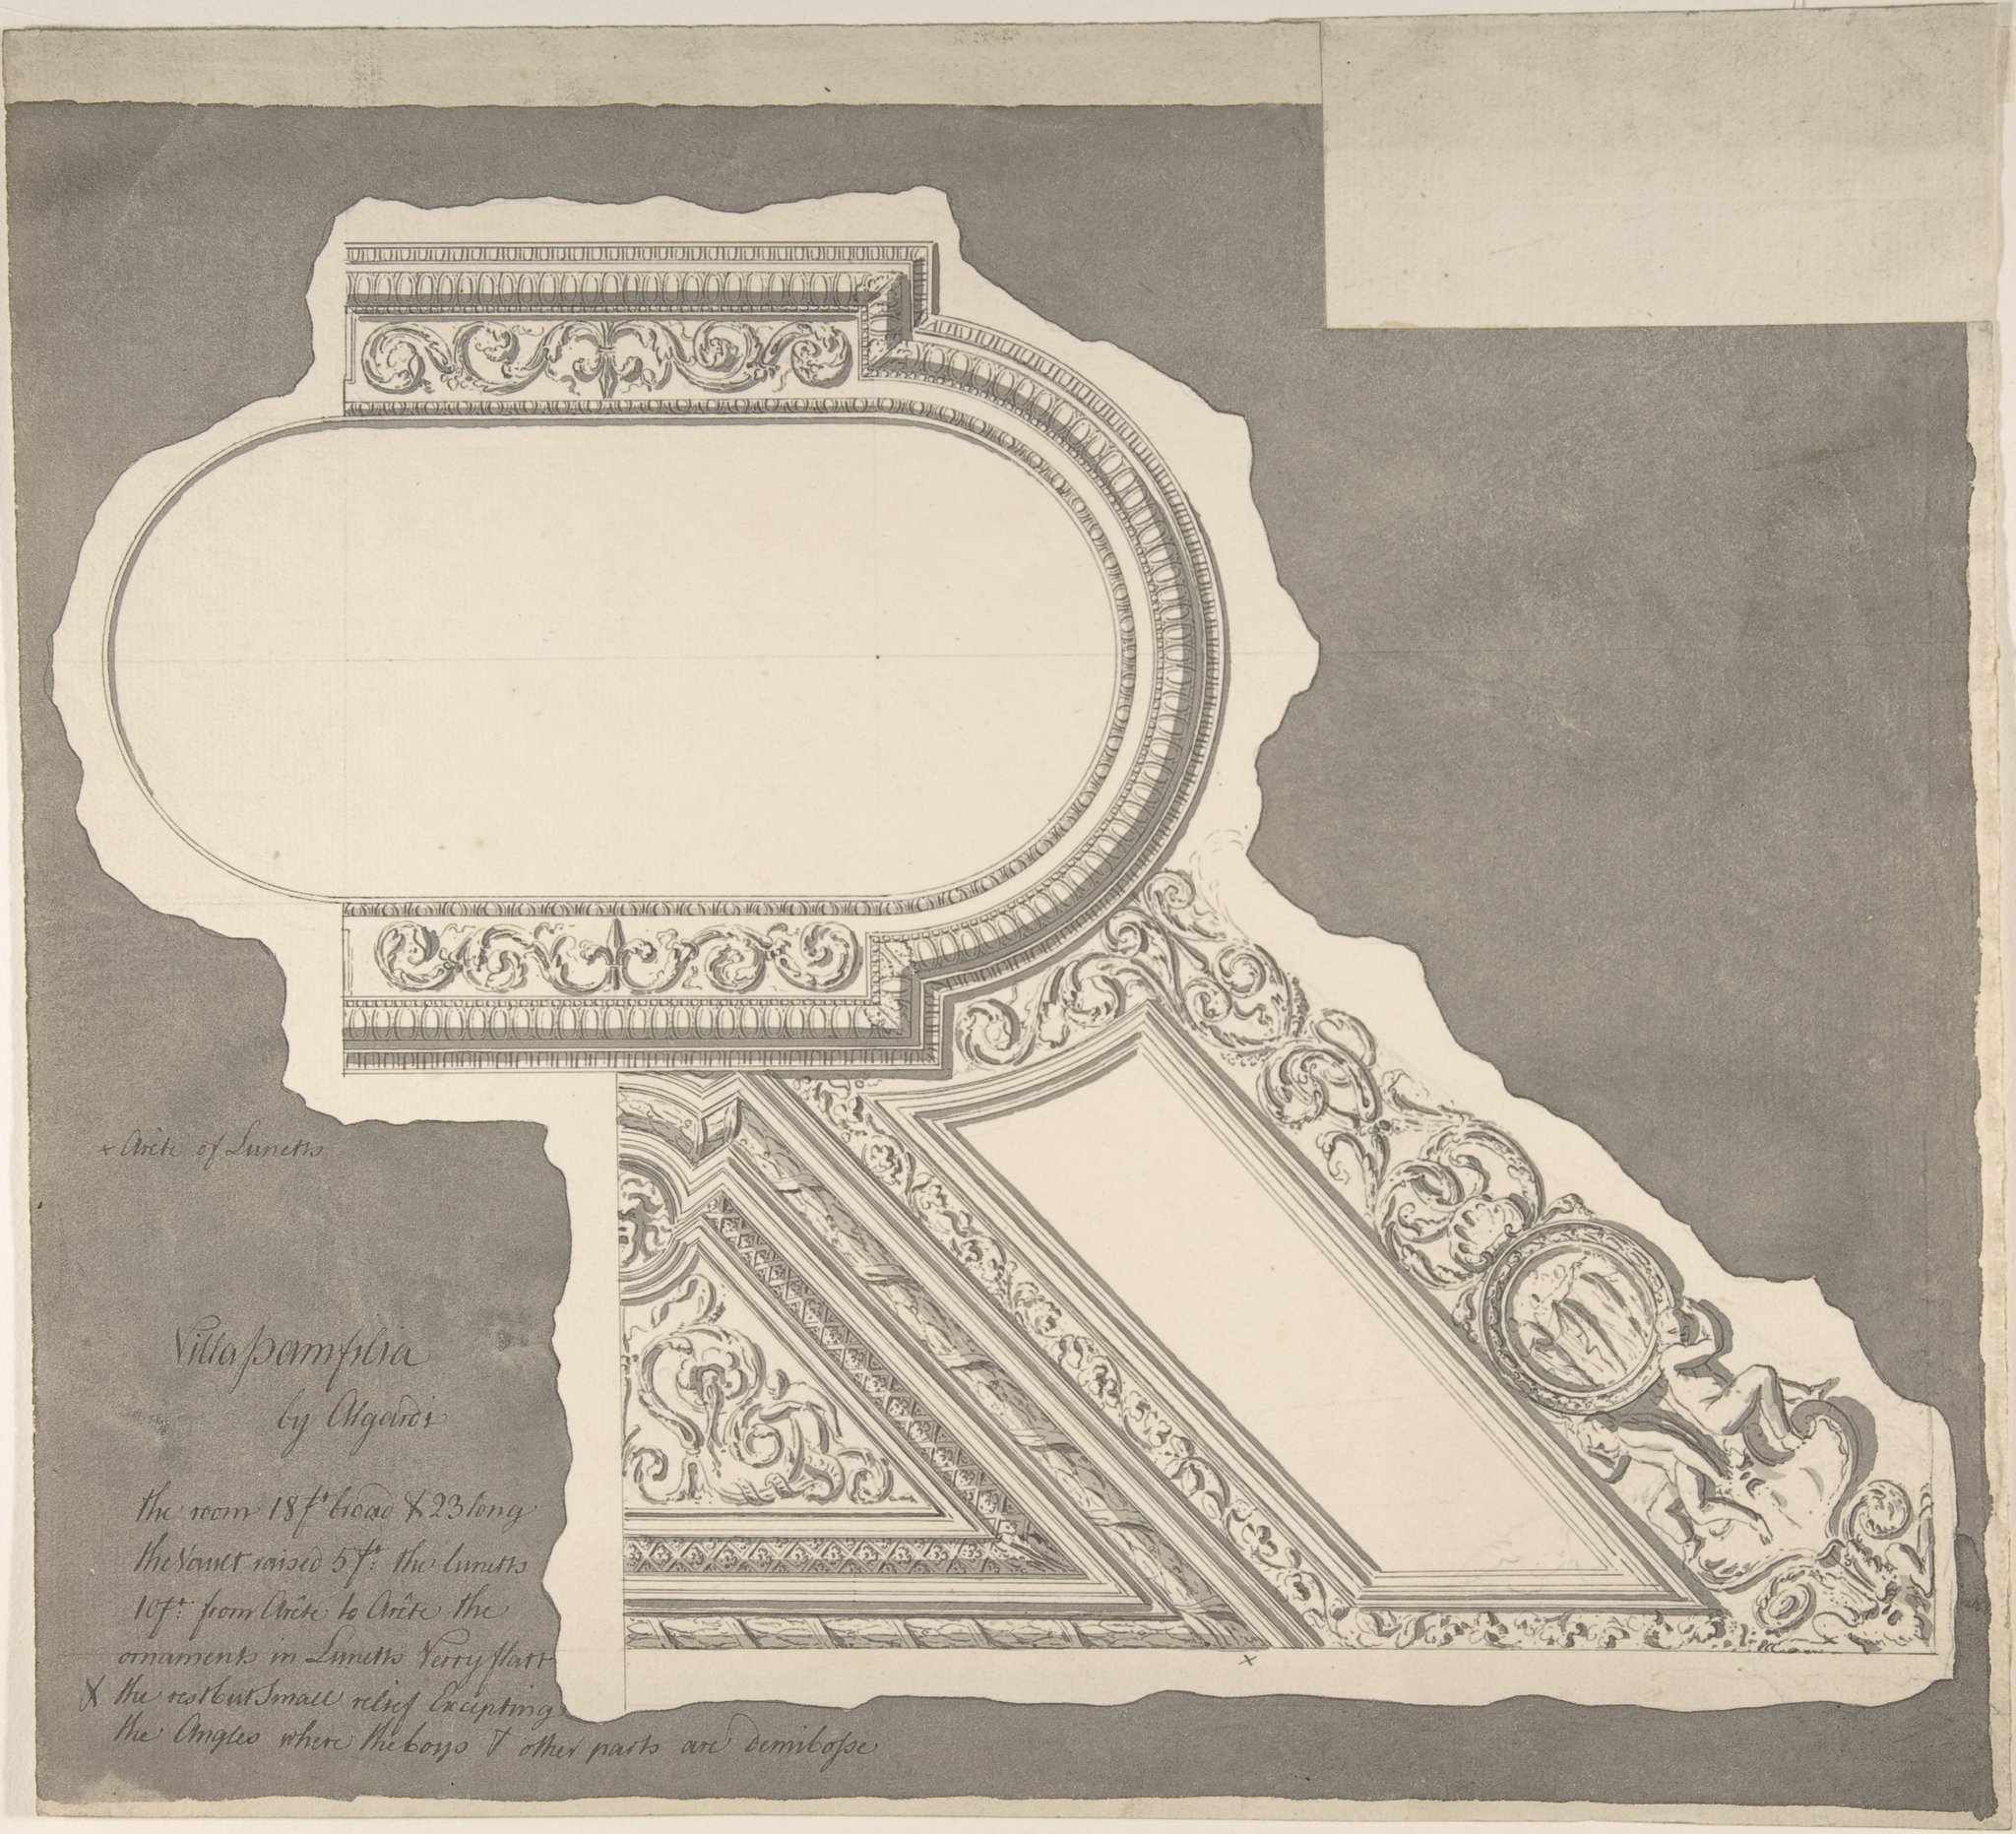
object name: drawing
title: Ceiling of Staircase, Palazzo Mattei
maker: sir william chambers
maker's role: artist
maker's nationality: british, born sweden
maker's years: 1723-1796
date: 1750-1755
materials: ink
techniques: brush, pen, wash